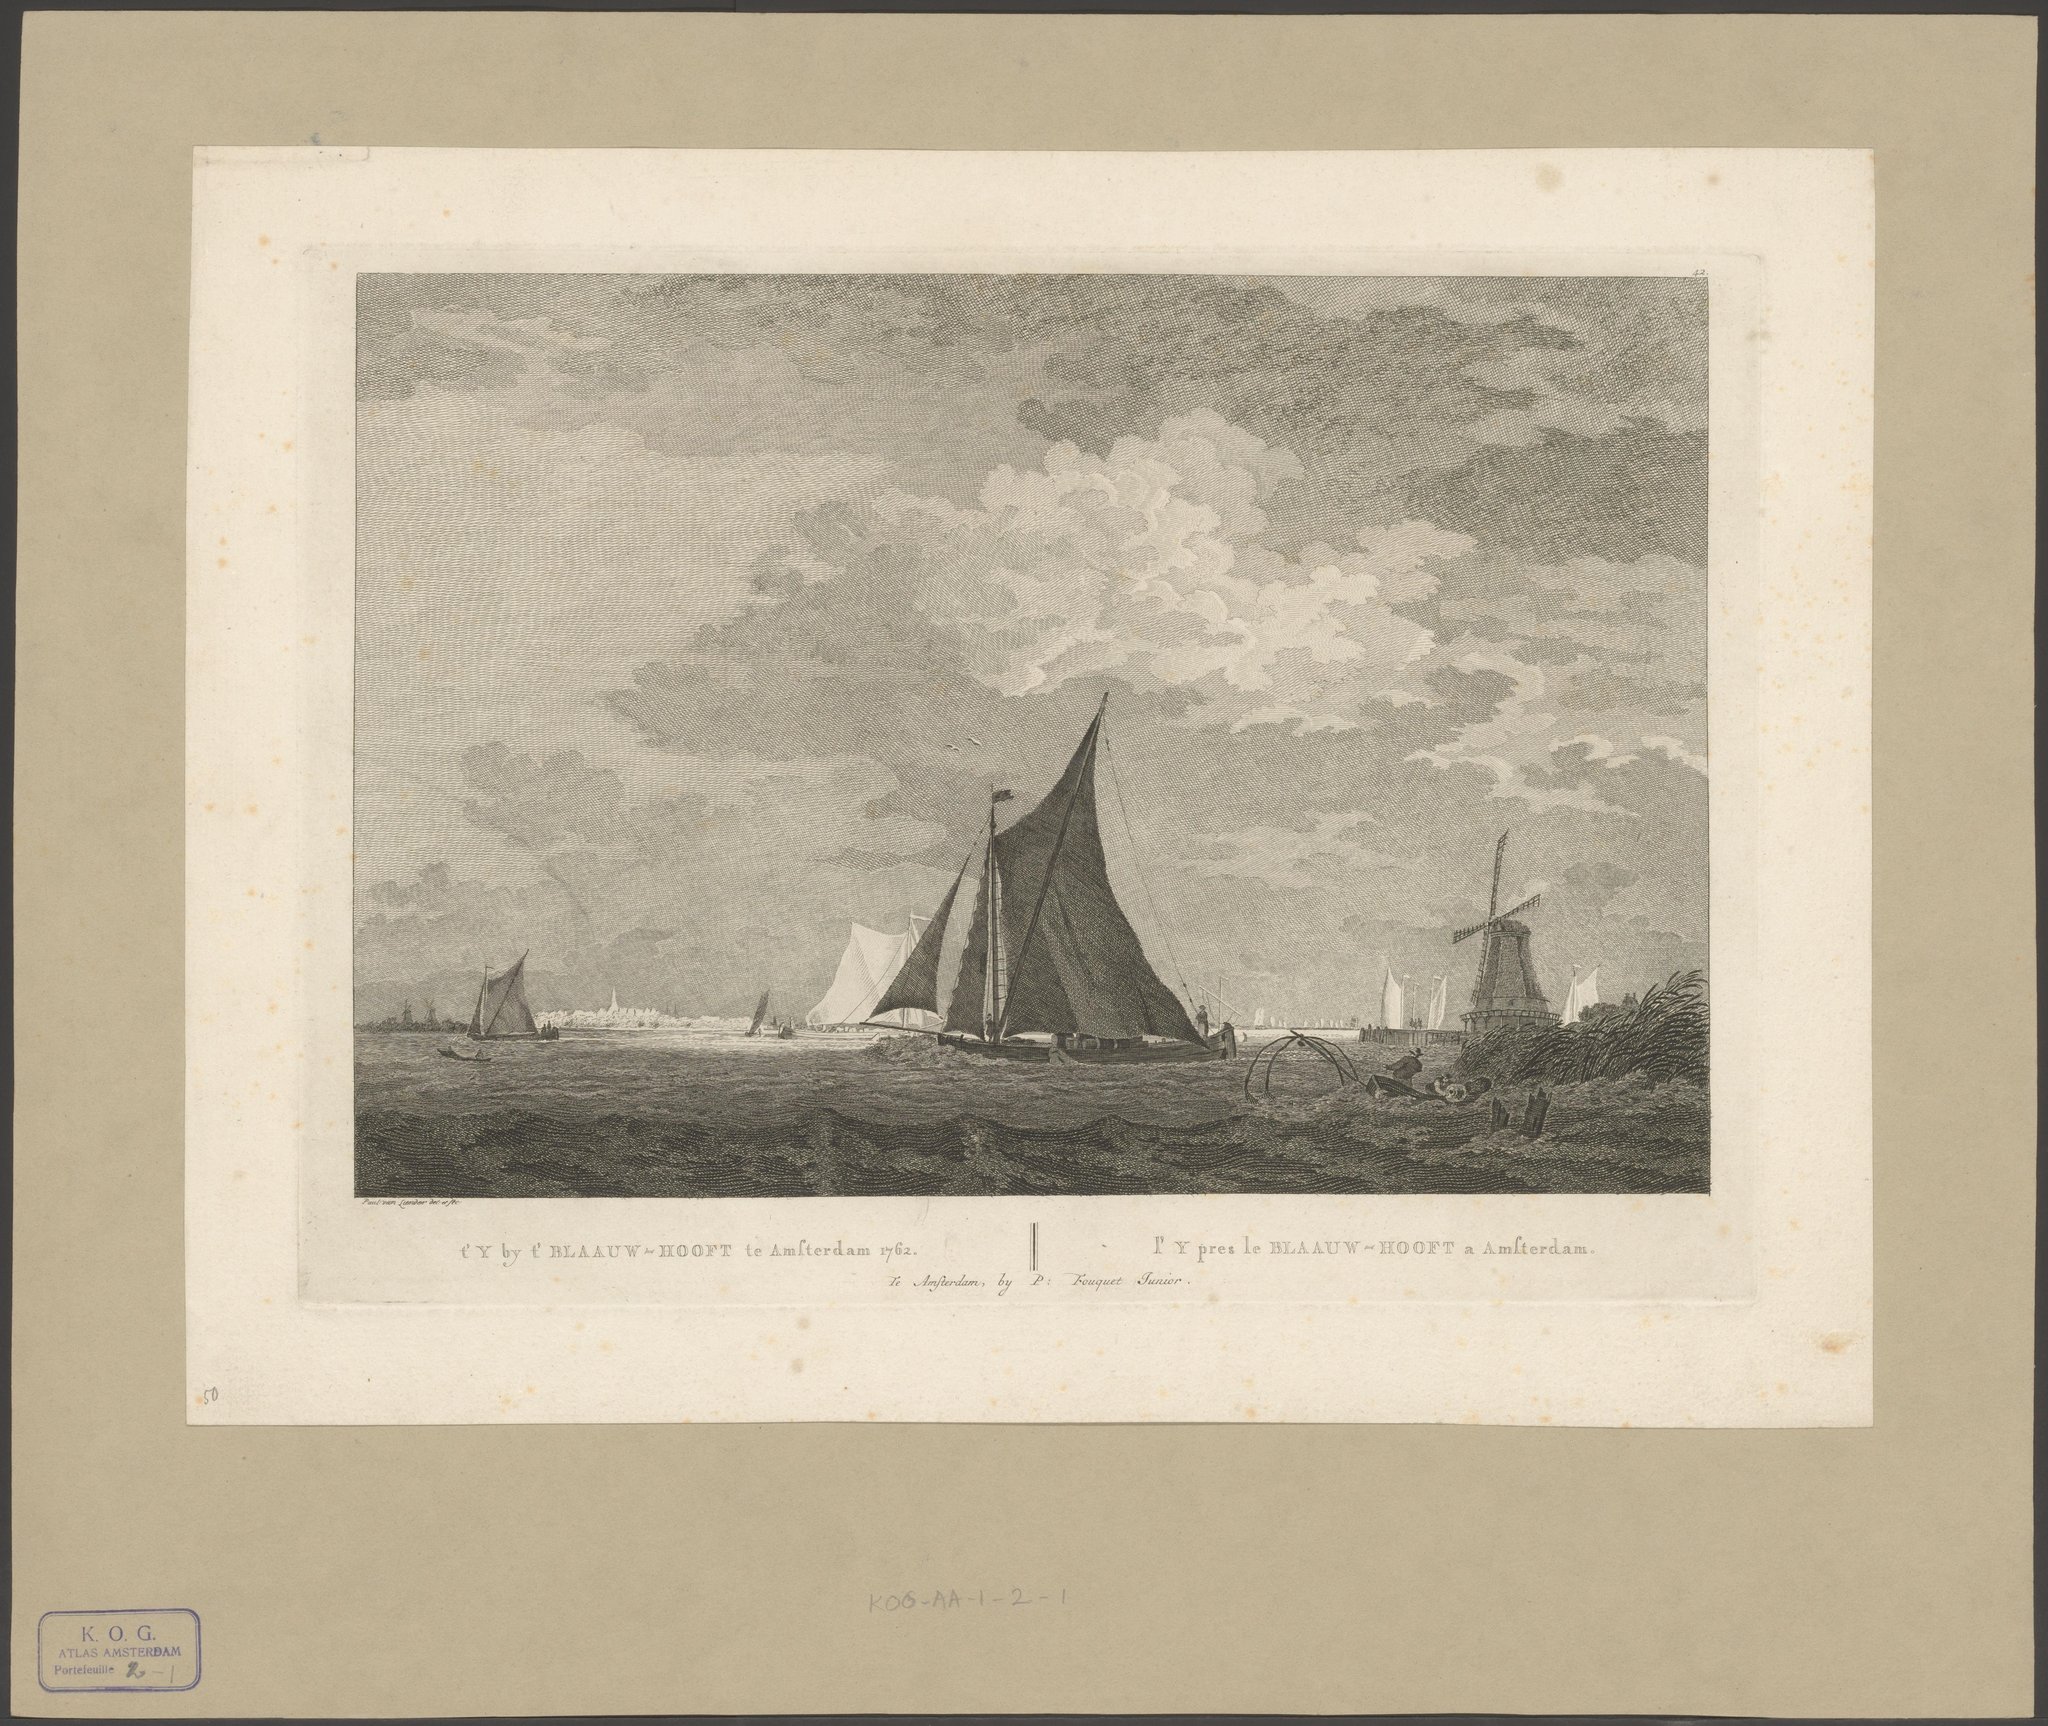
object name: print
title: Schepen op het IJ bij het Blauwhoofd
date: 1762-1783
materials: paper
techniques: engraving, etching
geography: amsterdam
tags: city-view in general; 'veduta', river, windmill in landscape, ships (in general) - cc - more than one ship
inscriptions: collector's mark: ‘2-1’ Lugt 1641b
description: Deze prent is ook gebruikt in de zogenaamde Atlas van Fouquet.* Pierre Fouquet gaf vanaf 1760 stadsgezichten van Amsterdam - naar tekeningen van verschillende kunstenaars, gemaakt door verschillende prentmakers - uit. Deze prenten werden aanvankelijk los of in series verkocht. Zoals toen gebruikelijk kon de koper de prenten zelf laten inbinden. Hiertoe gaf Fouquet tussen 1778 en 1783 een titelblad, plattegrond en inhoudsopgave van de tot dusver 100 uitgegeven prenten uit (1). Gezien de inhoud afhankelijk was van wat de koper had verzameld verschilt de inhoud van de verschillende bewaarde Fouquetatlassen onder deze titel sterk. Ook zijn er exemplaren bekend waar tevens andere prenten aan zijn toegevoegd. Omdat er behoefte bleek aan uitleg bij de platen werd in 1783 een nieuwe versie van de atlas uitgegeven, aangevuld met tekst en twee prenten. De aangegeven volgorde veranderde maar de platen van de al eerder uitgegeven prenten bleven ongewijzigd. Deze uitgave werd in opdracht van Fouquet gedrukt bij Daniël Jean Changuion en Petrus den Hengst (2). Een tiental platen werd bijgewerkt en verscheen, met nieuw impressum, in het vervolg van Wagenaars geschiedenis van Amsterdam, uitgeven door Petrus Conradi en Folkert van der Plaats (3). Een aantal jaar na het overlijden van Fouquet kwam Evert Maaskamp met een nieuwe uitgave van de atlas, met verbeterde tekst en toevoeging van twee prenten. Op alle platen verwijderde hij het oude en liet hij zijn eigen impressum zetten (4). De huidige staat van de prent komt voor in exemplaren van de onder (1) en (2) genoemde werken. * Onder de Atlas van Fouquet of Fouquetatlas verstaan we de hieronder vermelde publicaties (1), (2) en (4). (1). Afbeeldingen van de wyd-vermaarde koopstad Amsterdam benevens des zelvs voornaamste gebouwen en gezigten alle naar het leeven getekend / Receuil des edifices les plus considerables et des plus belles vues, de la fameuse ville d'Amsterdam, dessinées d'après nature. Amsterdam: Pierre Fouquet, 1778-1783. (2). Nieuwe atlas, van de voornaamste gebouwen en gezigten der stad Amsterdam, met derzelver beknopte beschryvingen. 2 delen. Amsterdam: Daniël Jean Changuion en Petrus den Hengst [in opdracht van Pierre Fouquet], 1783. (3). Stijl, Simon. Amsterdam, in zyne geschiedenissen, voorregten, koophandel, gebouwen, kerkenstaat, schoolen, schutterye, gilden en regeeringe, beschreeven. Om te dienen ten vervolge op het werk van Jan Wagenaar (…). 10 delen. Amsterdam en Harlingen: Petrus Conradi en Folkert van der Plaats, 1788-1801. (4). Nieuwe atlas, van de voornaamste gebouwen en gezigten der stad Amsterdam. Met derzelver beknopte beschryvingen. Amsterdam: Evert Maaskamp, 1805. * Het aantal vermelde staten is gebaseerd op het aantal gevonden staten. Mogelijk zijn er meer staten van deze prent. Voor tweede bekende staat zie RP-P-OB-46.343. Voor derde bekende staat zie RP-P-1911-3088.